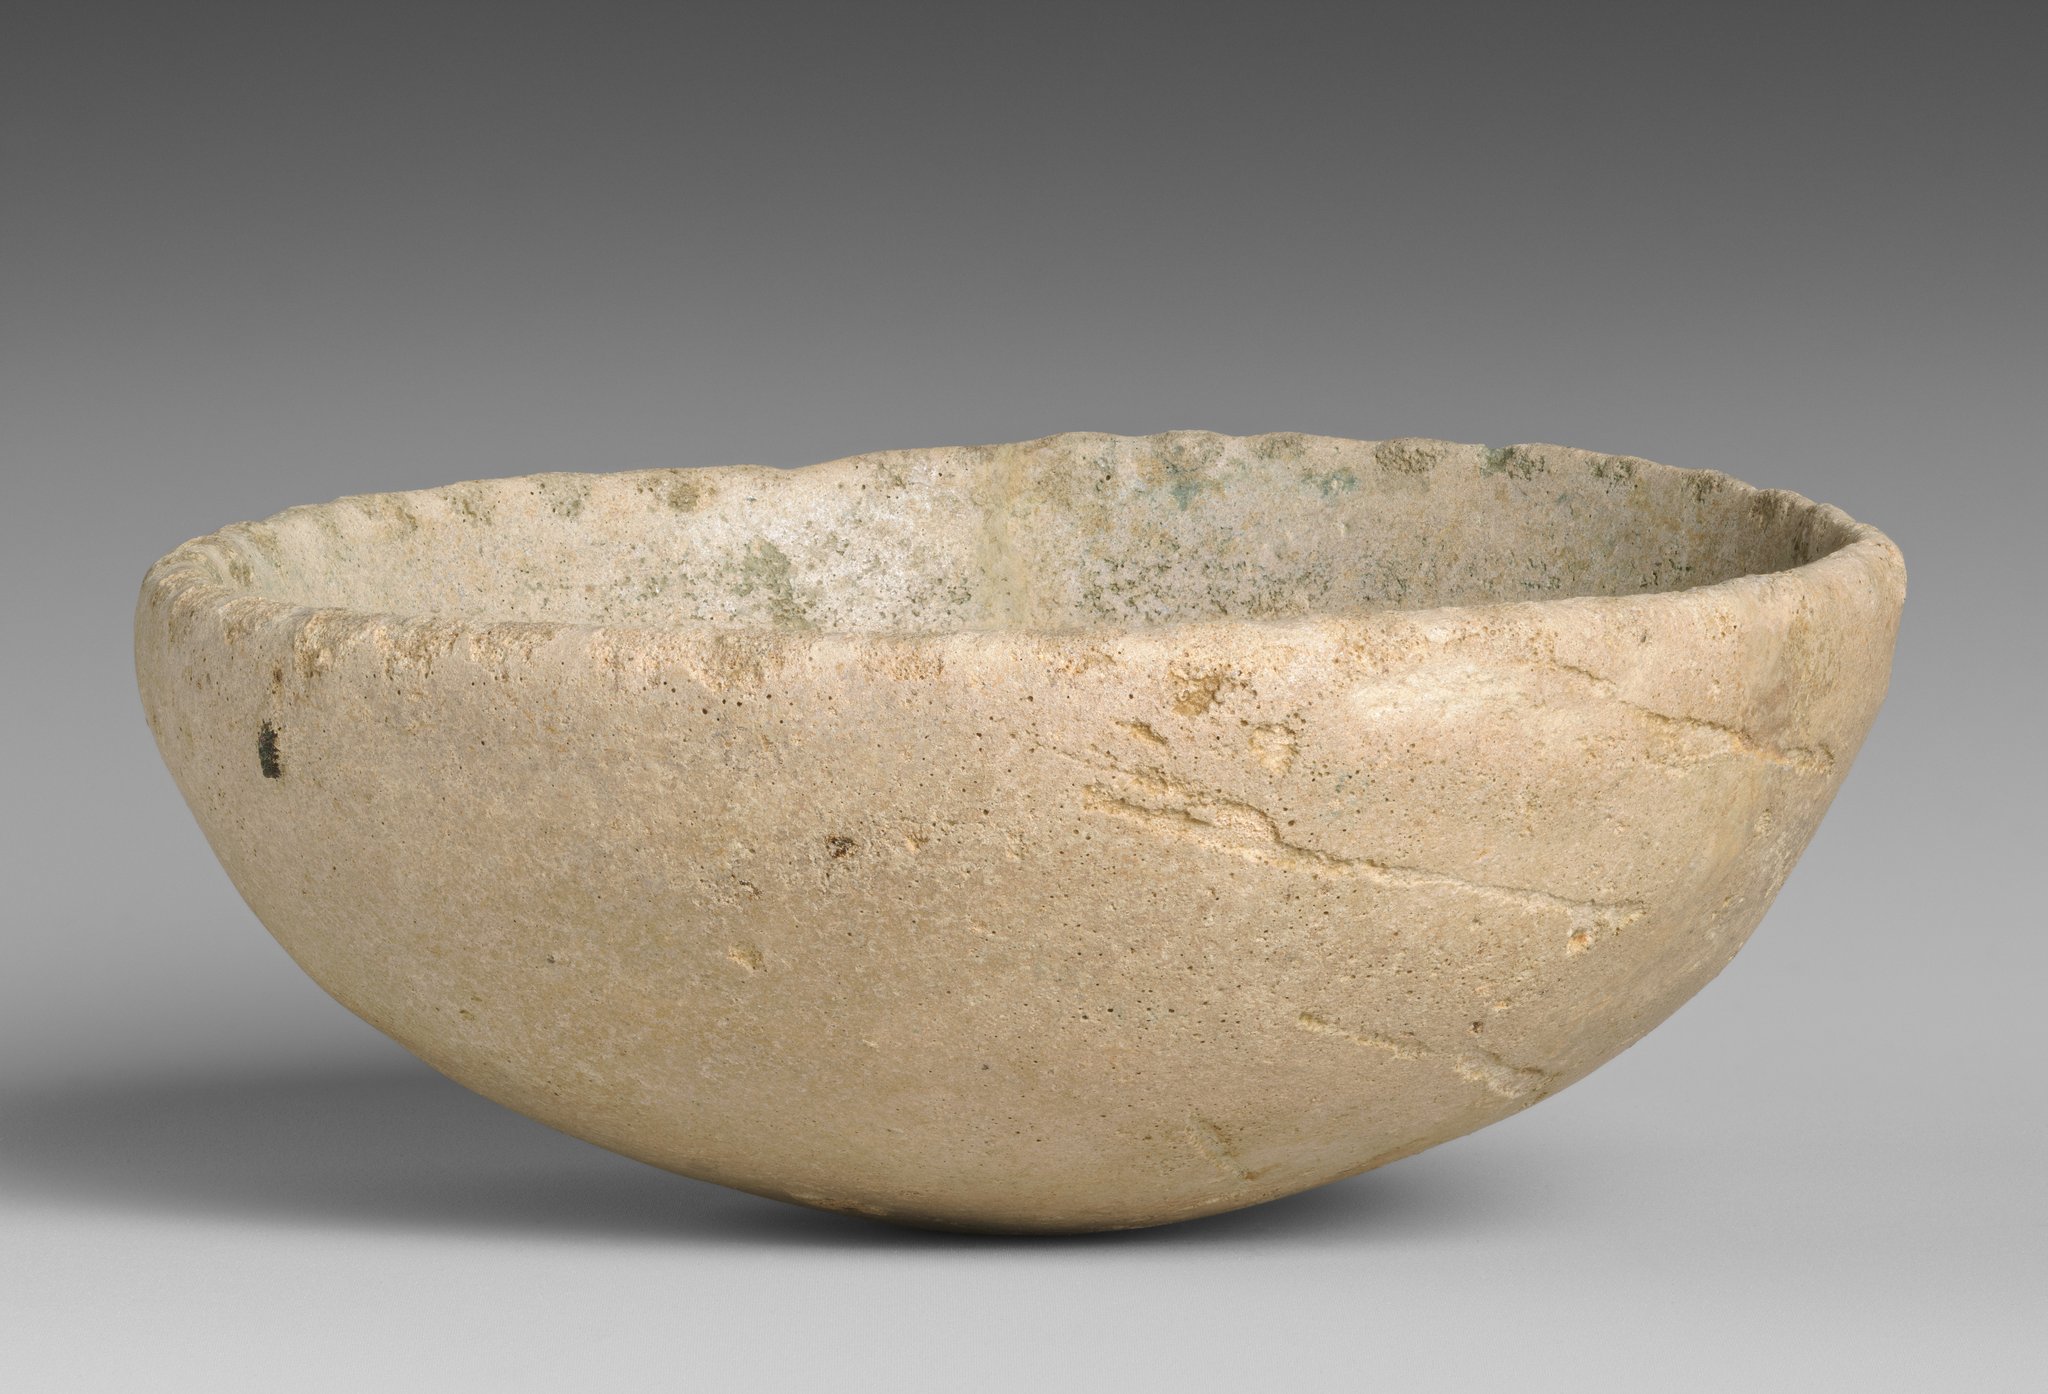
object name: bowl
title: Faience bowl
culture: cypriot or levantine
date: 1300-1101 BCE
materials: faience